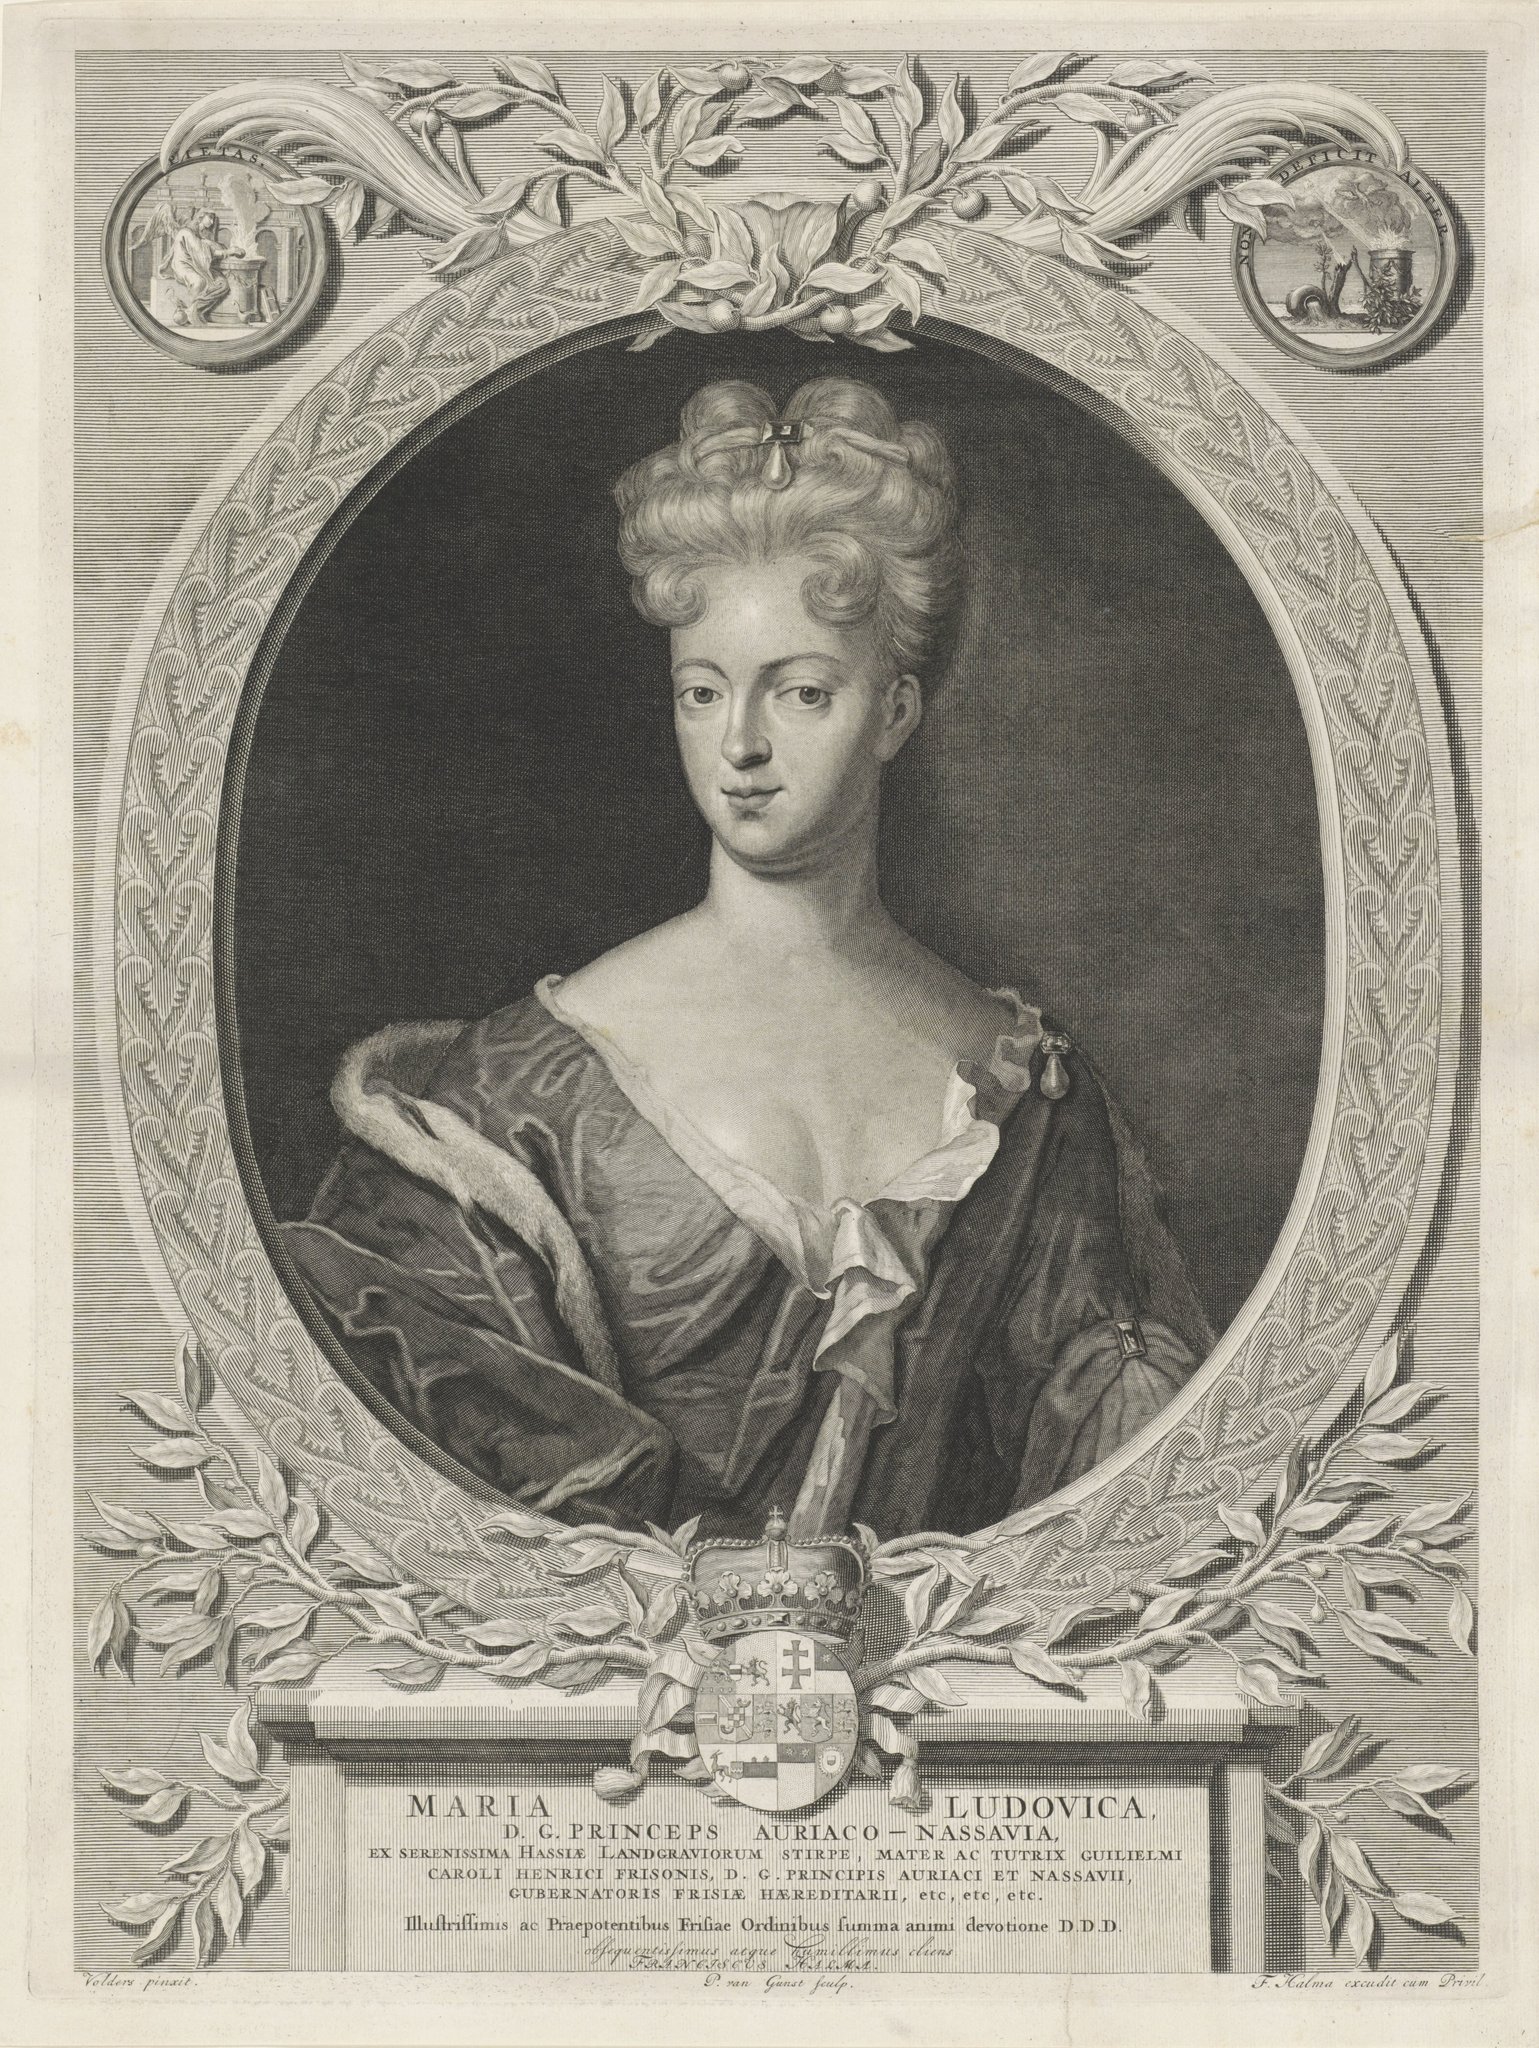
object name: print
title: Portret van Maria Louisa van Hessen-Kassel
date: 1709-1722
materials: paper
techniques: engraving, etching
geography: northern netherlands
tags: kassel, leeuwarden, maria louisa van hessen-kassel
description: Portret van Maria Louisa in een geornamenteerd ovaal met oranjetakken. Linksboven en rechtsboven een allegorische voorstelling in een cirkel met randschrift. Midden onder haar wapen met een kroon. Op een voetstuk haar naam, haar titels en twee regels Latijnse tekst.